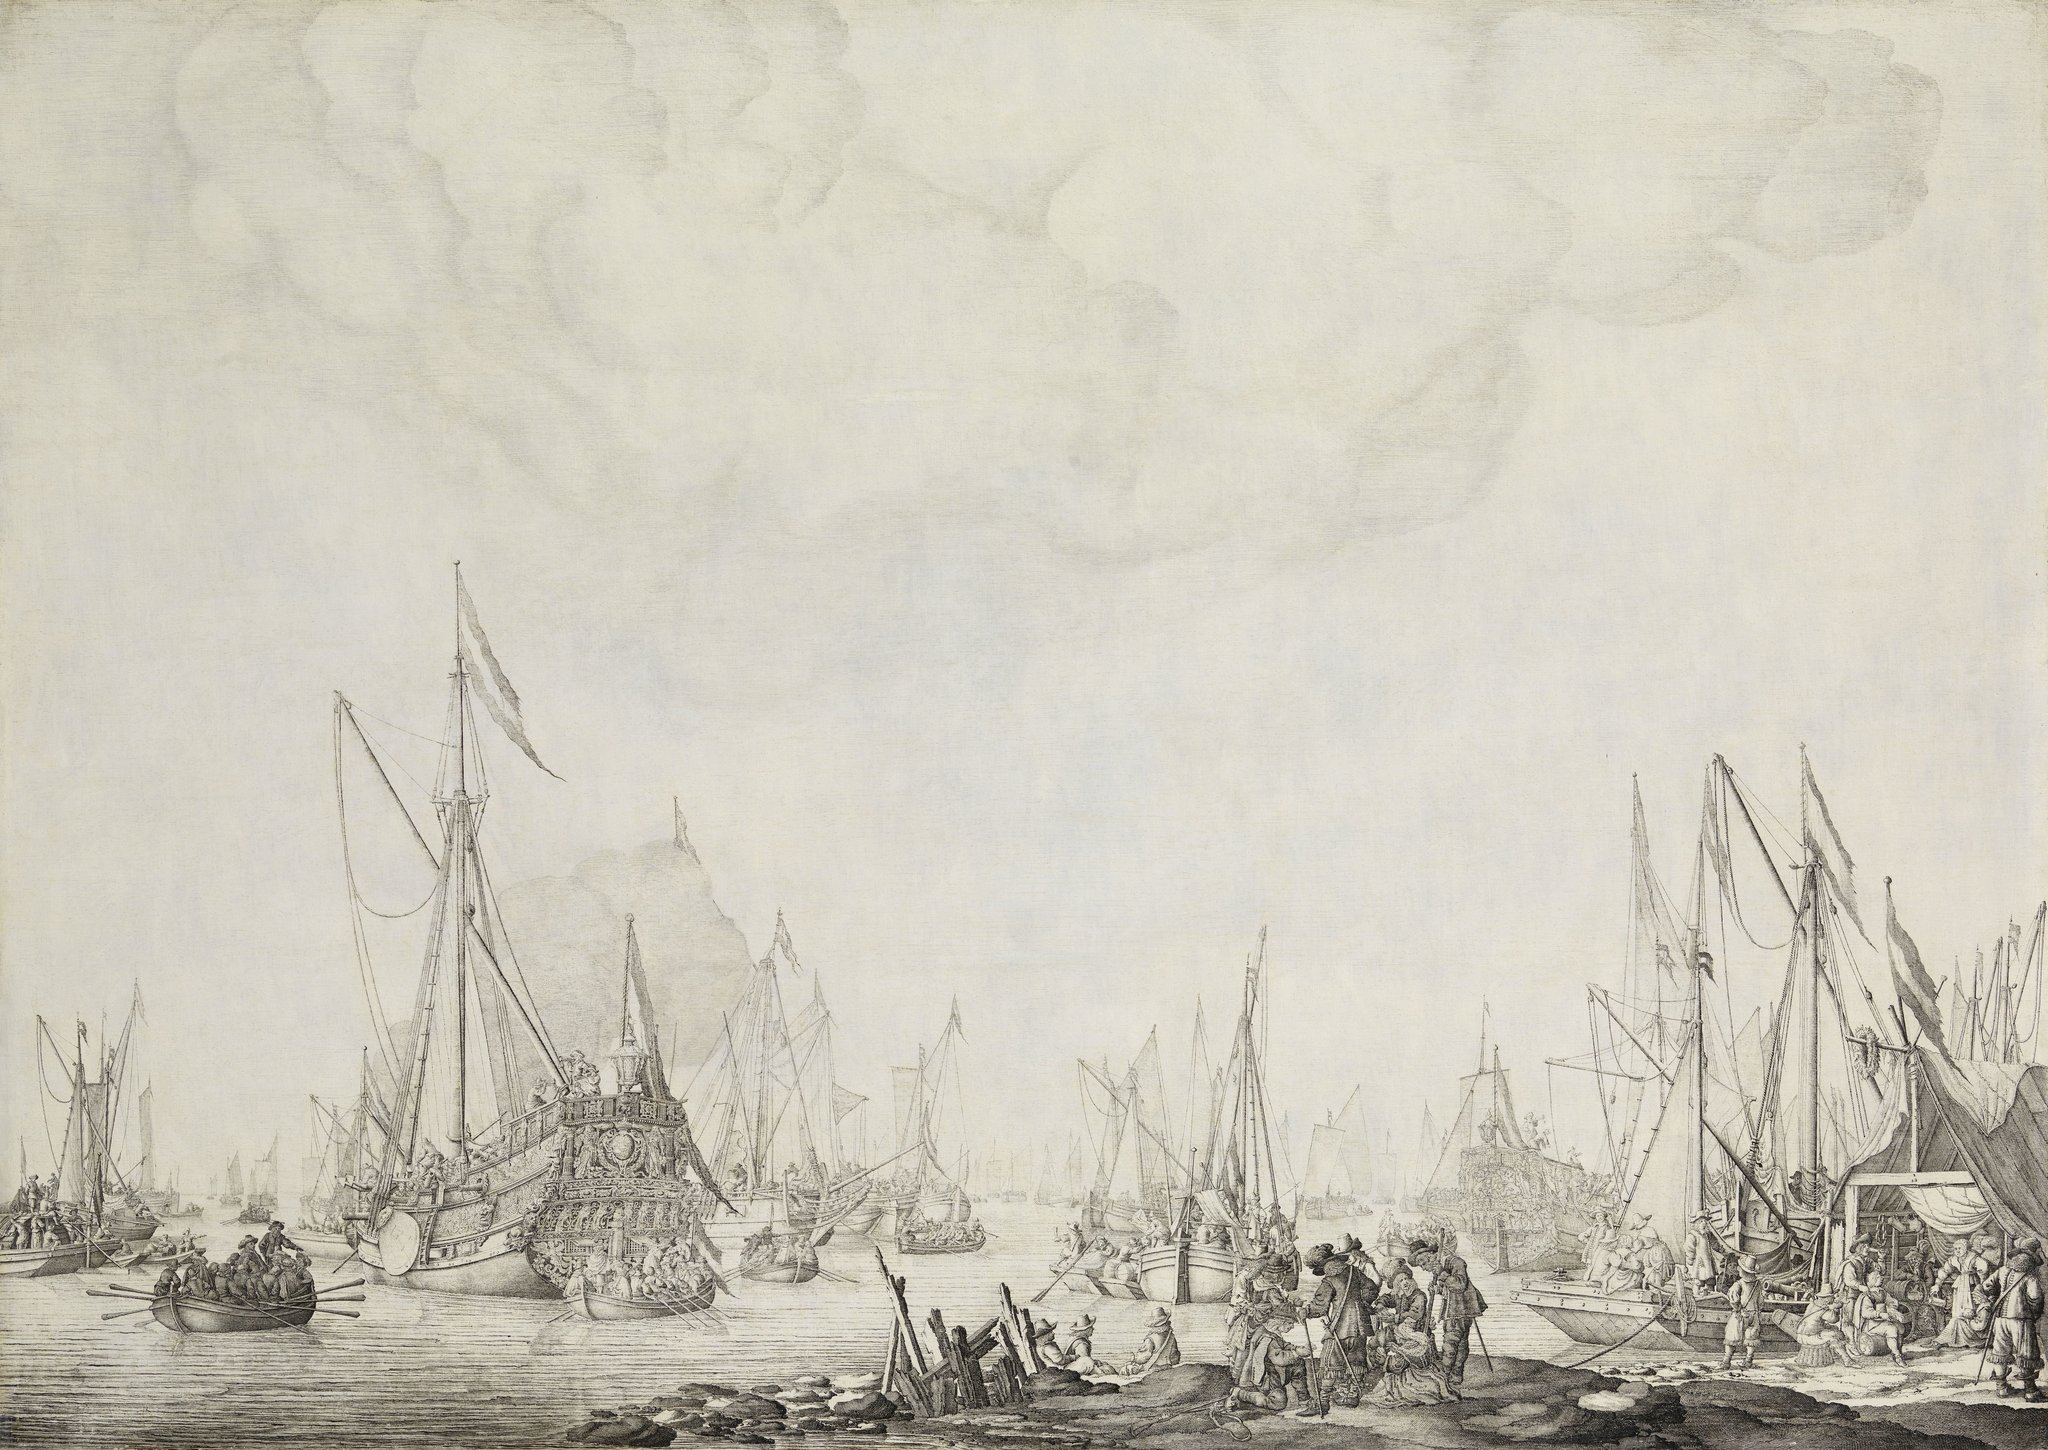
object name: penschildering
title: The Royal and State Yachts, possibly the Arrival of Charles II of England at Moerdijk, 1660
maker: willem van de velde (i)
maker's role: draughtsman, painter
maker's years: 1611-1693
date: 1660-1693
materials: ink, panel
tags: karel ii (koning van engeland), harbour, sailing-ship, sailing-boat (with name)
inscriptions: signature: ‘W. v.d. Velde’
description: Het Prinsenjacht en het Statenjacht, vermoedelijk de komst van Karel II, koning van Engeland, afwachtend bij Moerdijk, 1660. De jachten liggen voor anker in de haven tussen een vloot van andere kleine scheepjes en roeiboten. Aan de wal op de voorgrond een groep kaartende mannen, rechts een herberg met vrouwen en drinkende soldaten.